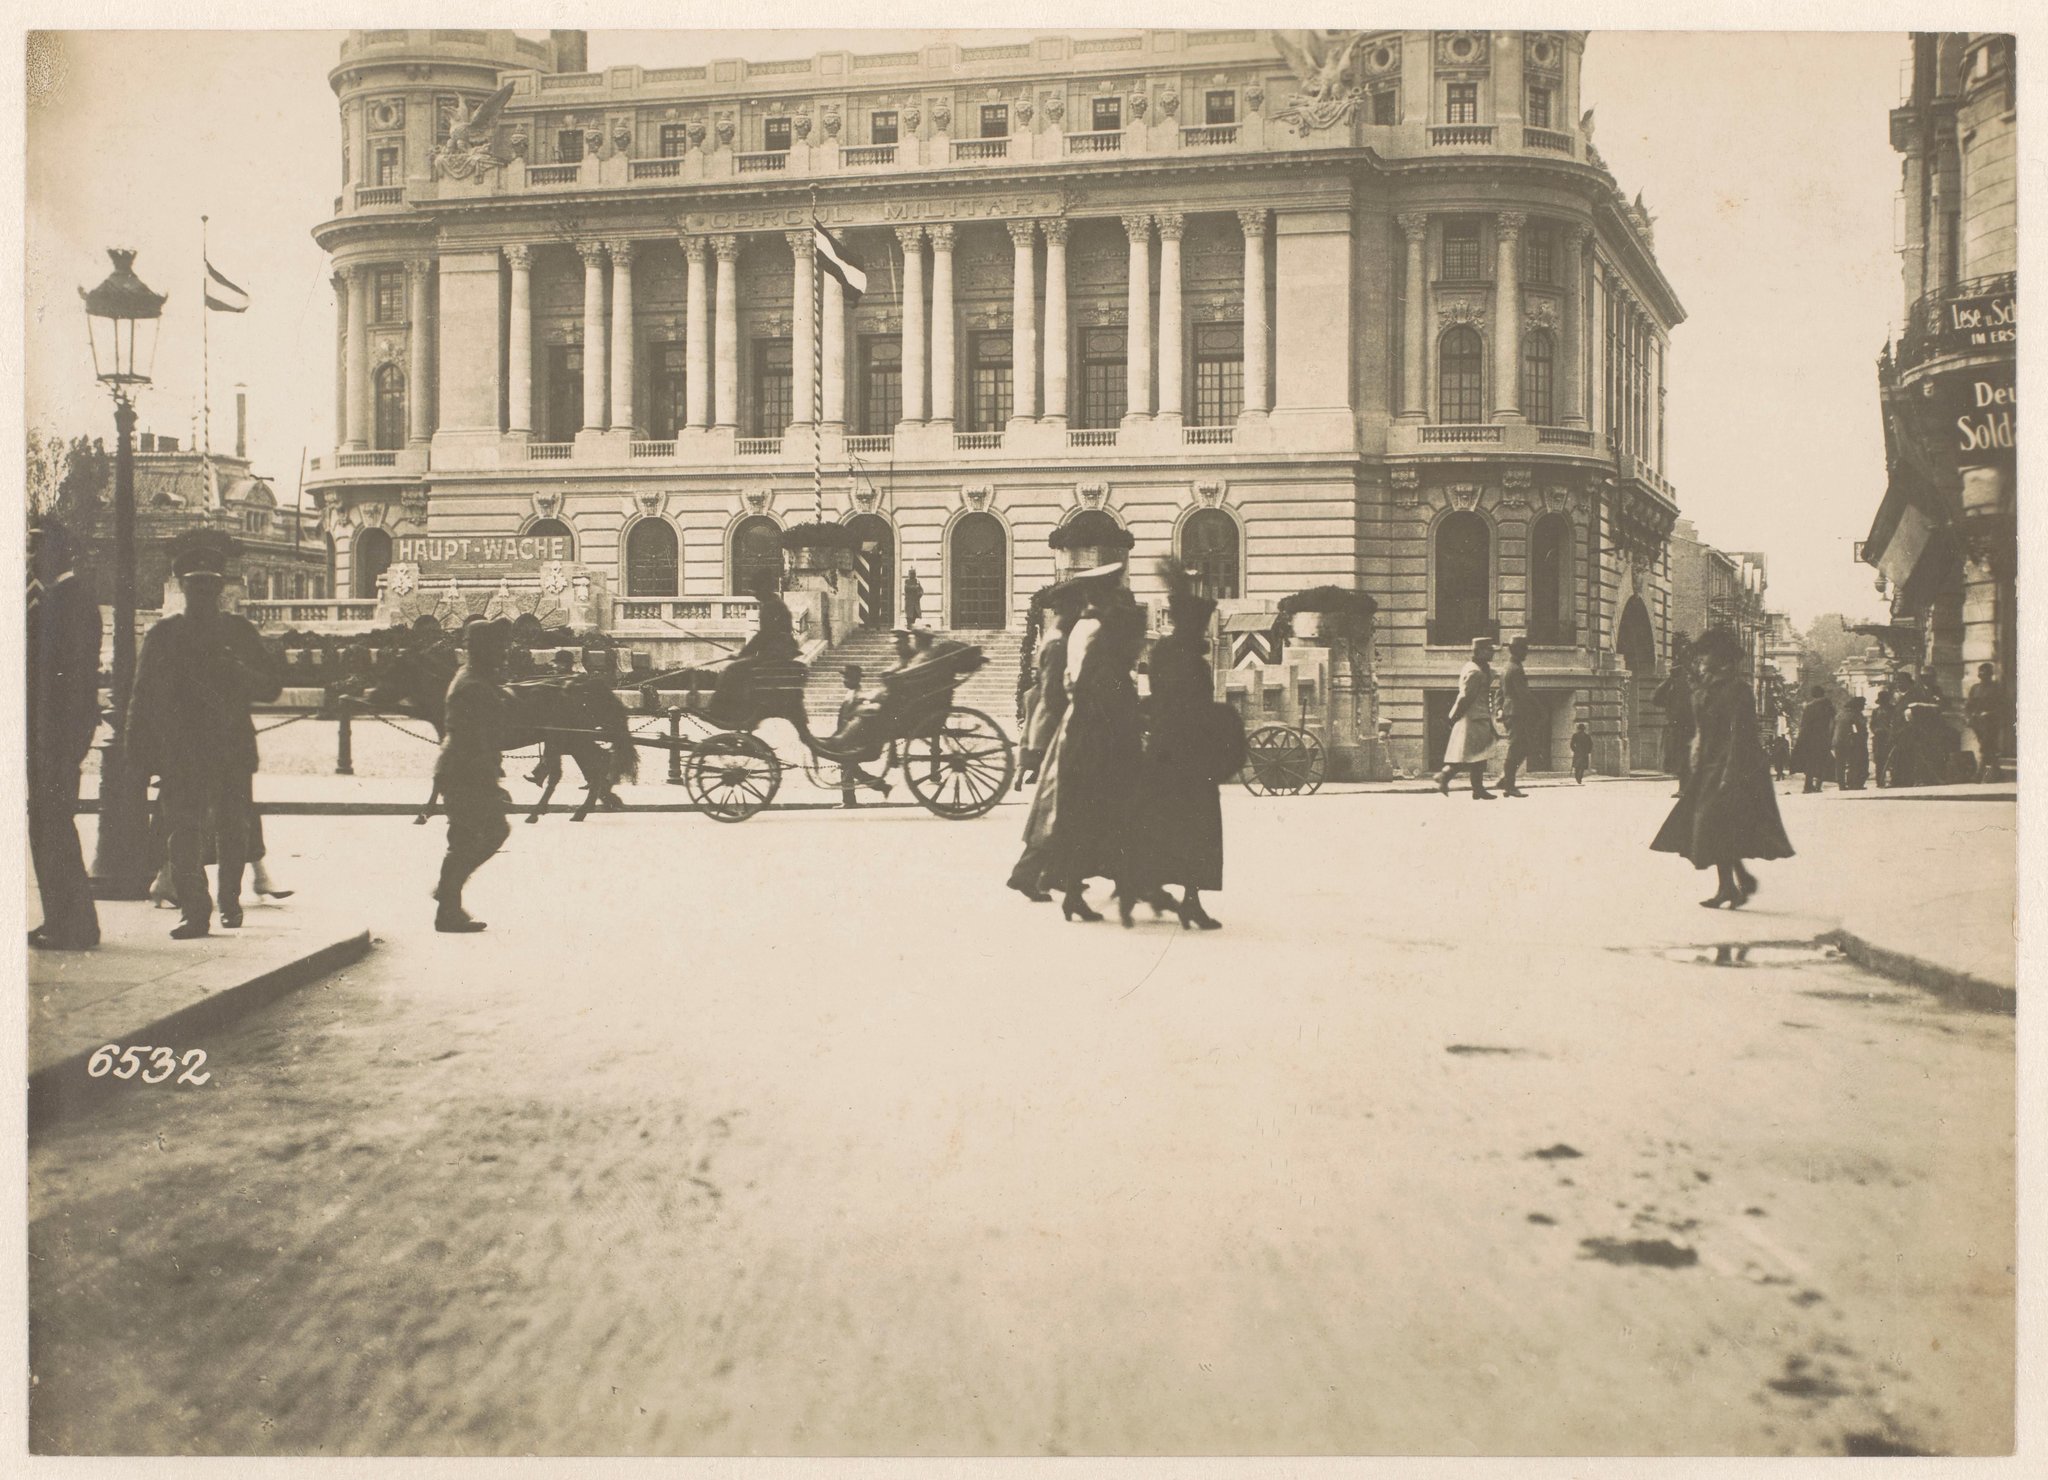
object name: photograph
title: Gezicht op het gebouw van de Roemeense Cercul Militar tijdens de Duitse bezetting van Boekarest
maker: Anonymous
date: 1916-1918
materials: paper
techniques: gelatin silver print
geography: bucharest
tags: street, edifice, e.g.: public building, department store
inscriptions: number: ‘6532’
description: tijdens de Eerste Wereldoorlog door Duitsers in gebruik als Hauptwache